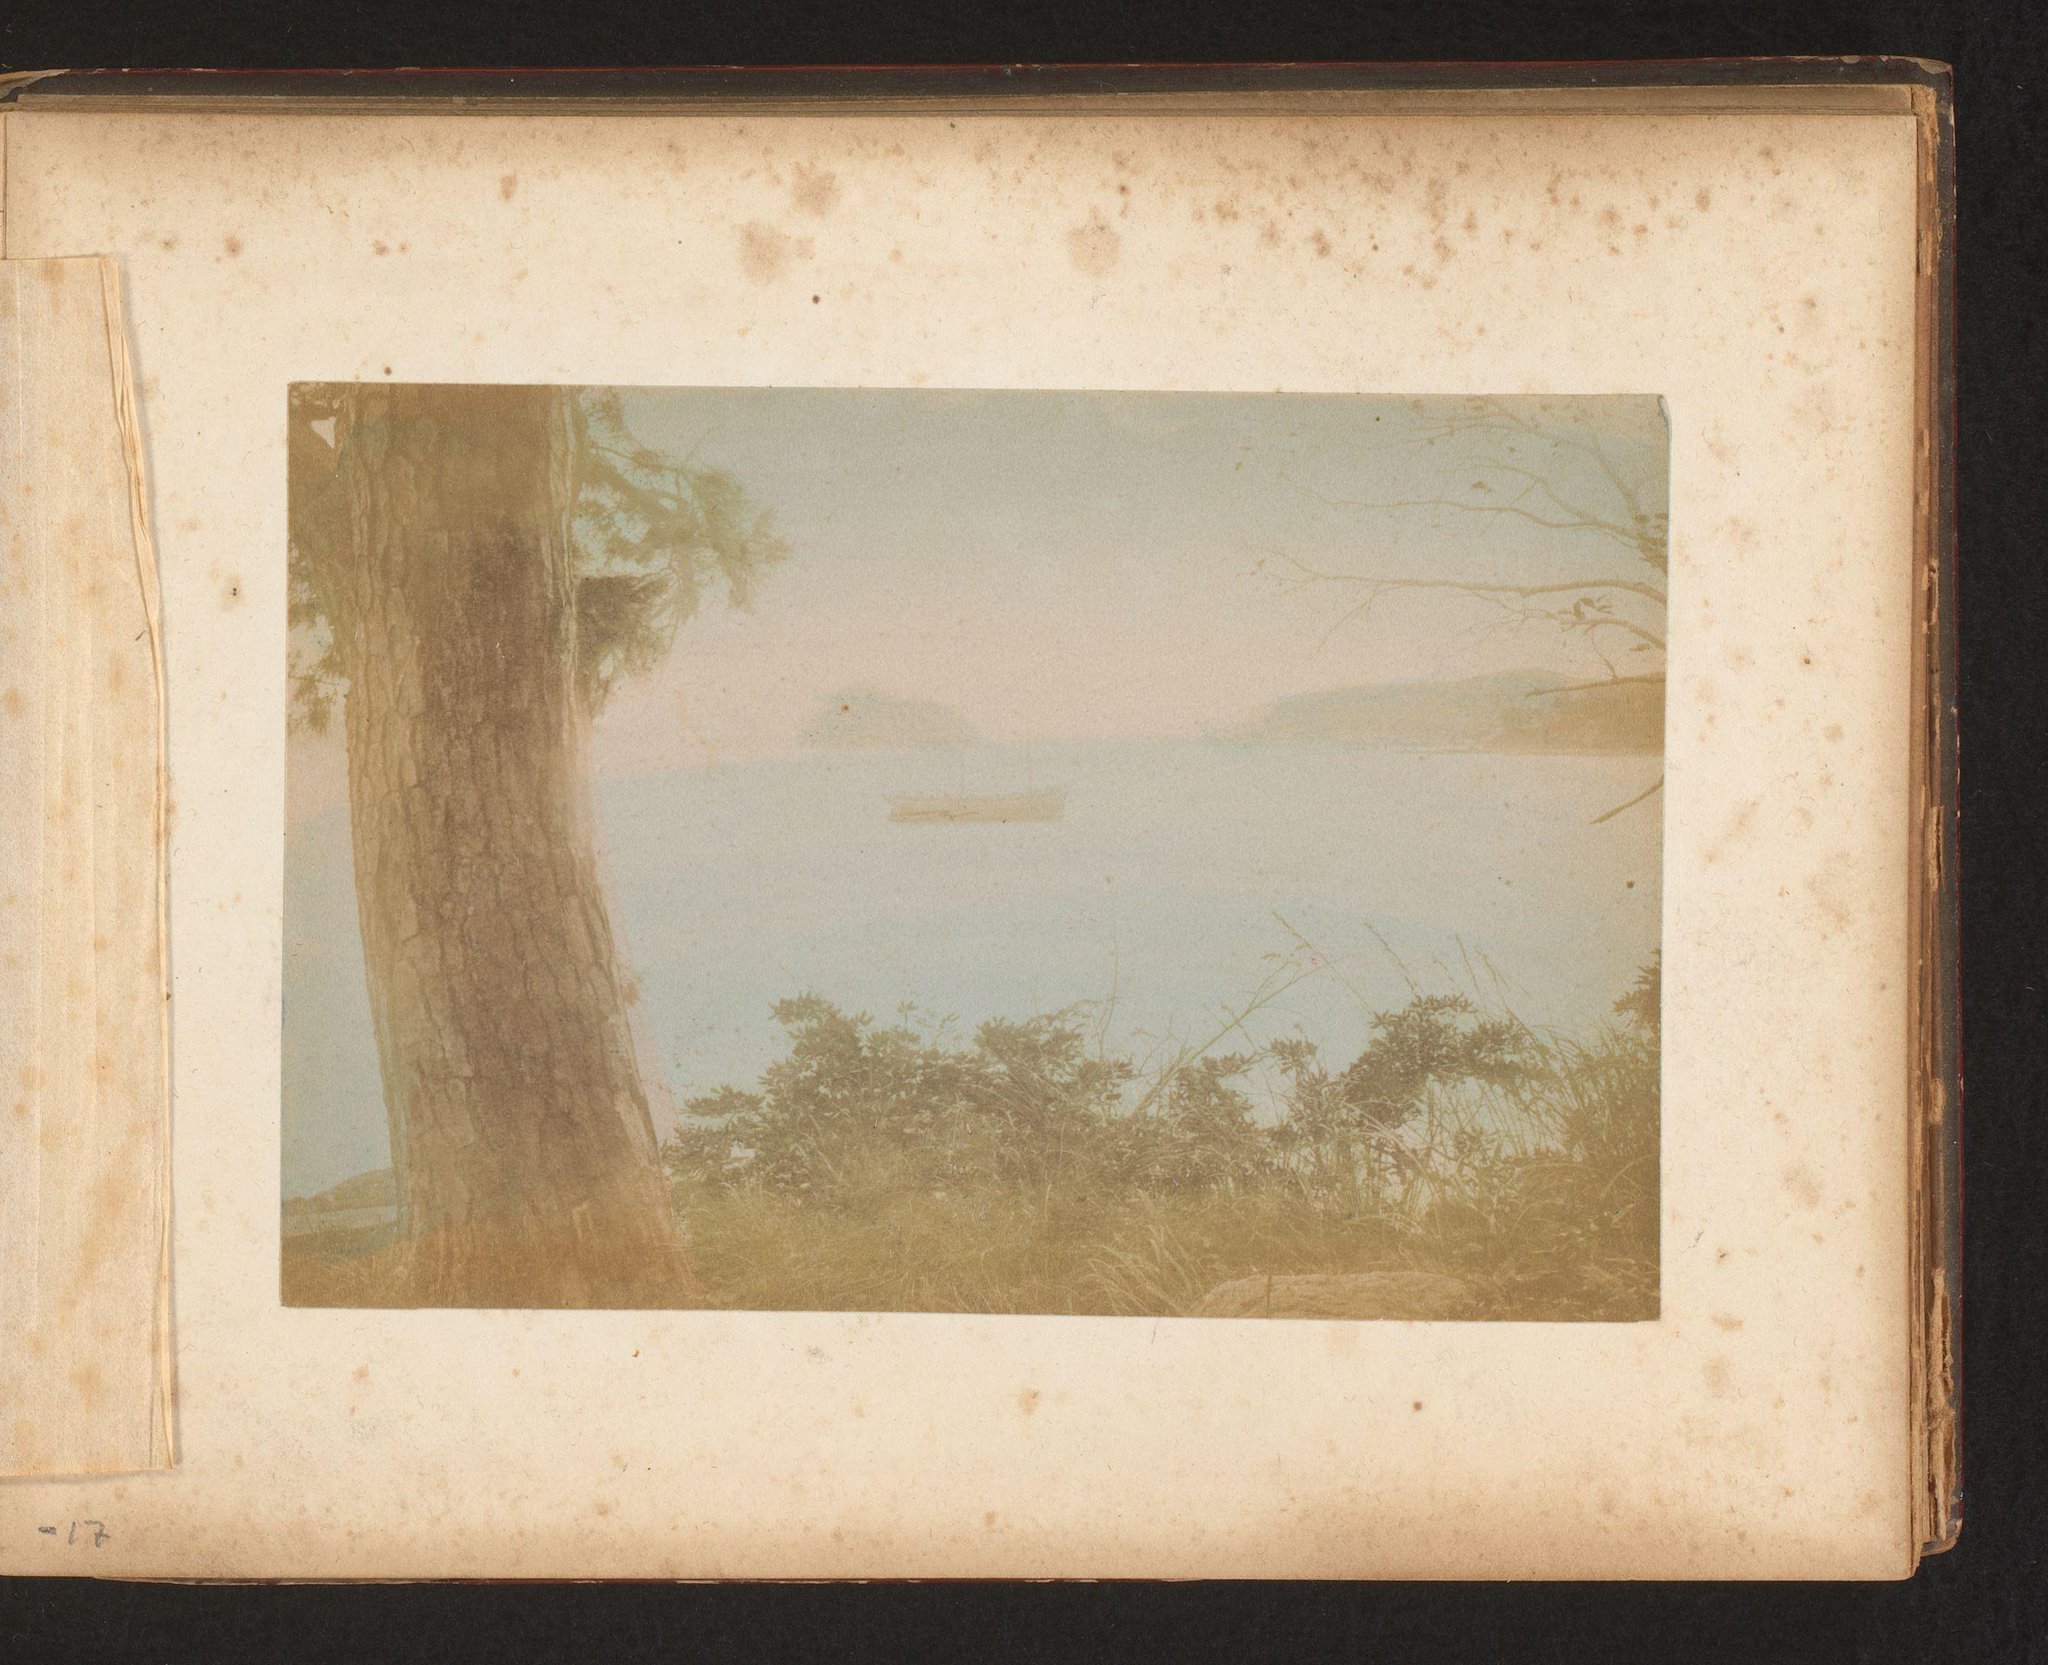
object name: photograph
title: Uitzicht over een lagune in Japan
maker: Anonymous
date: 1851-1900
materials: paper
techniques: albumen print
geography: japan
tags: haff, lagoon created by sand, shingle bank ~ coast, japan